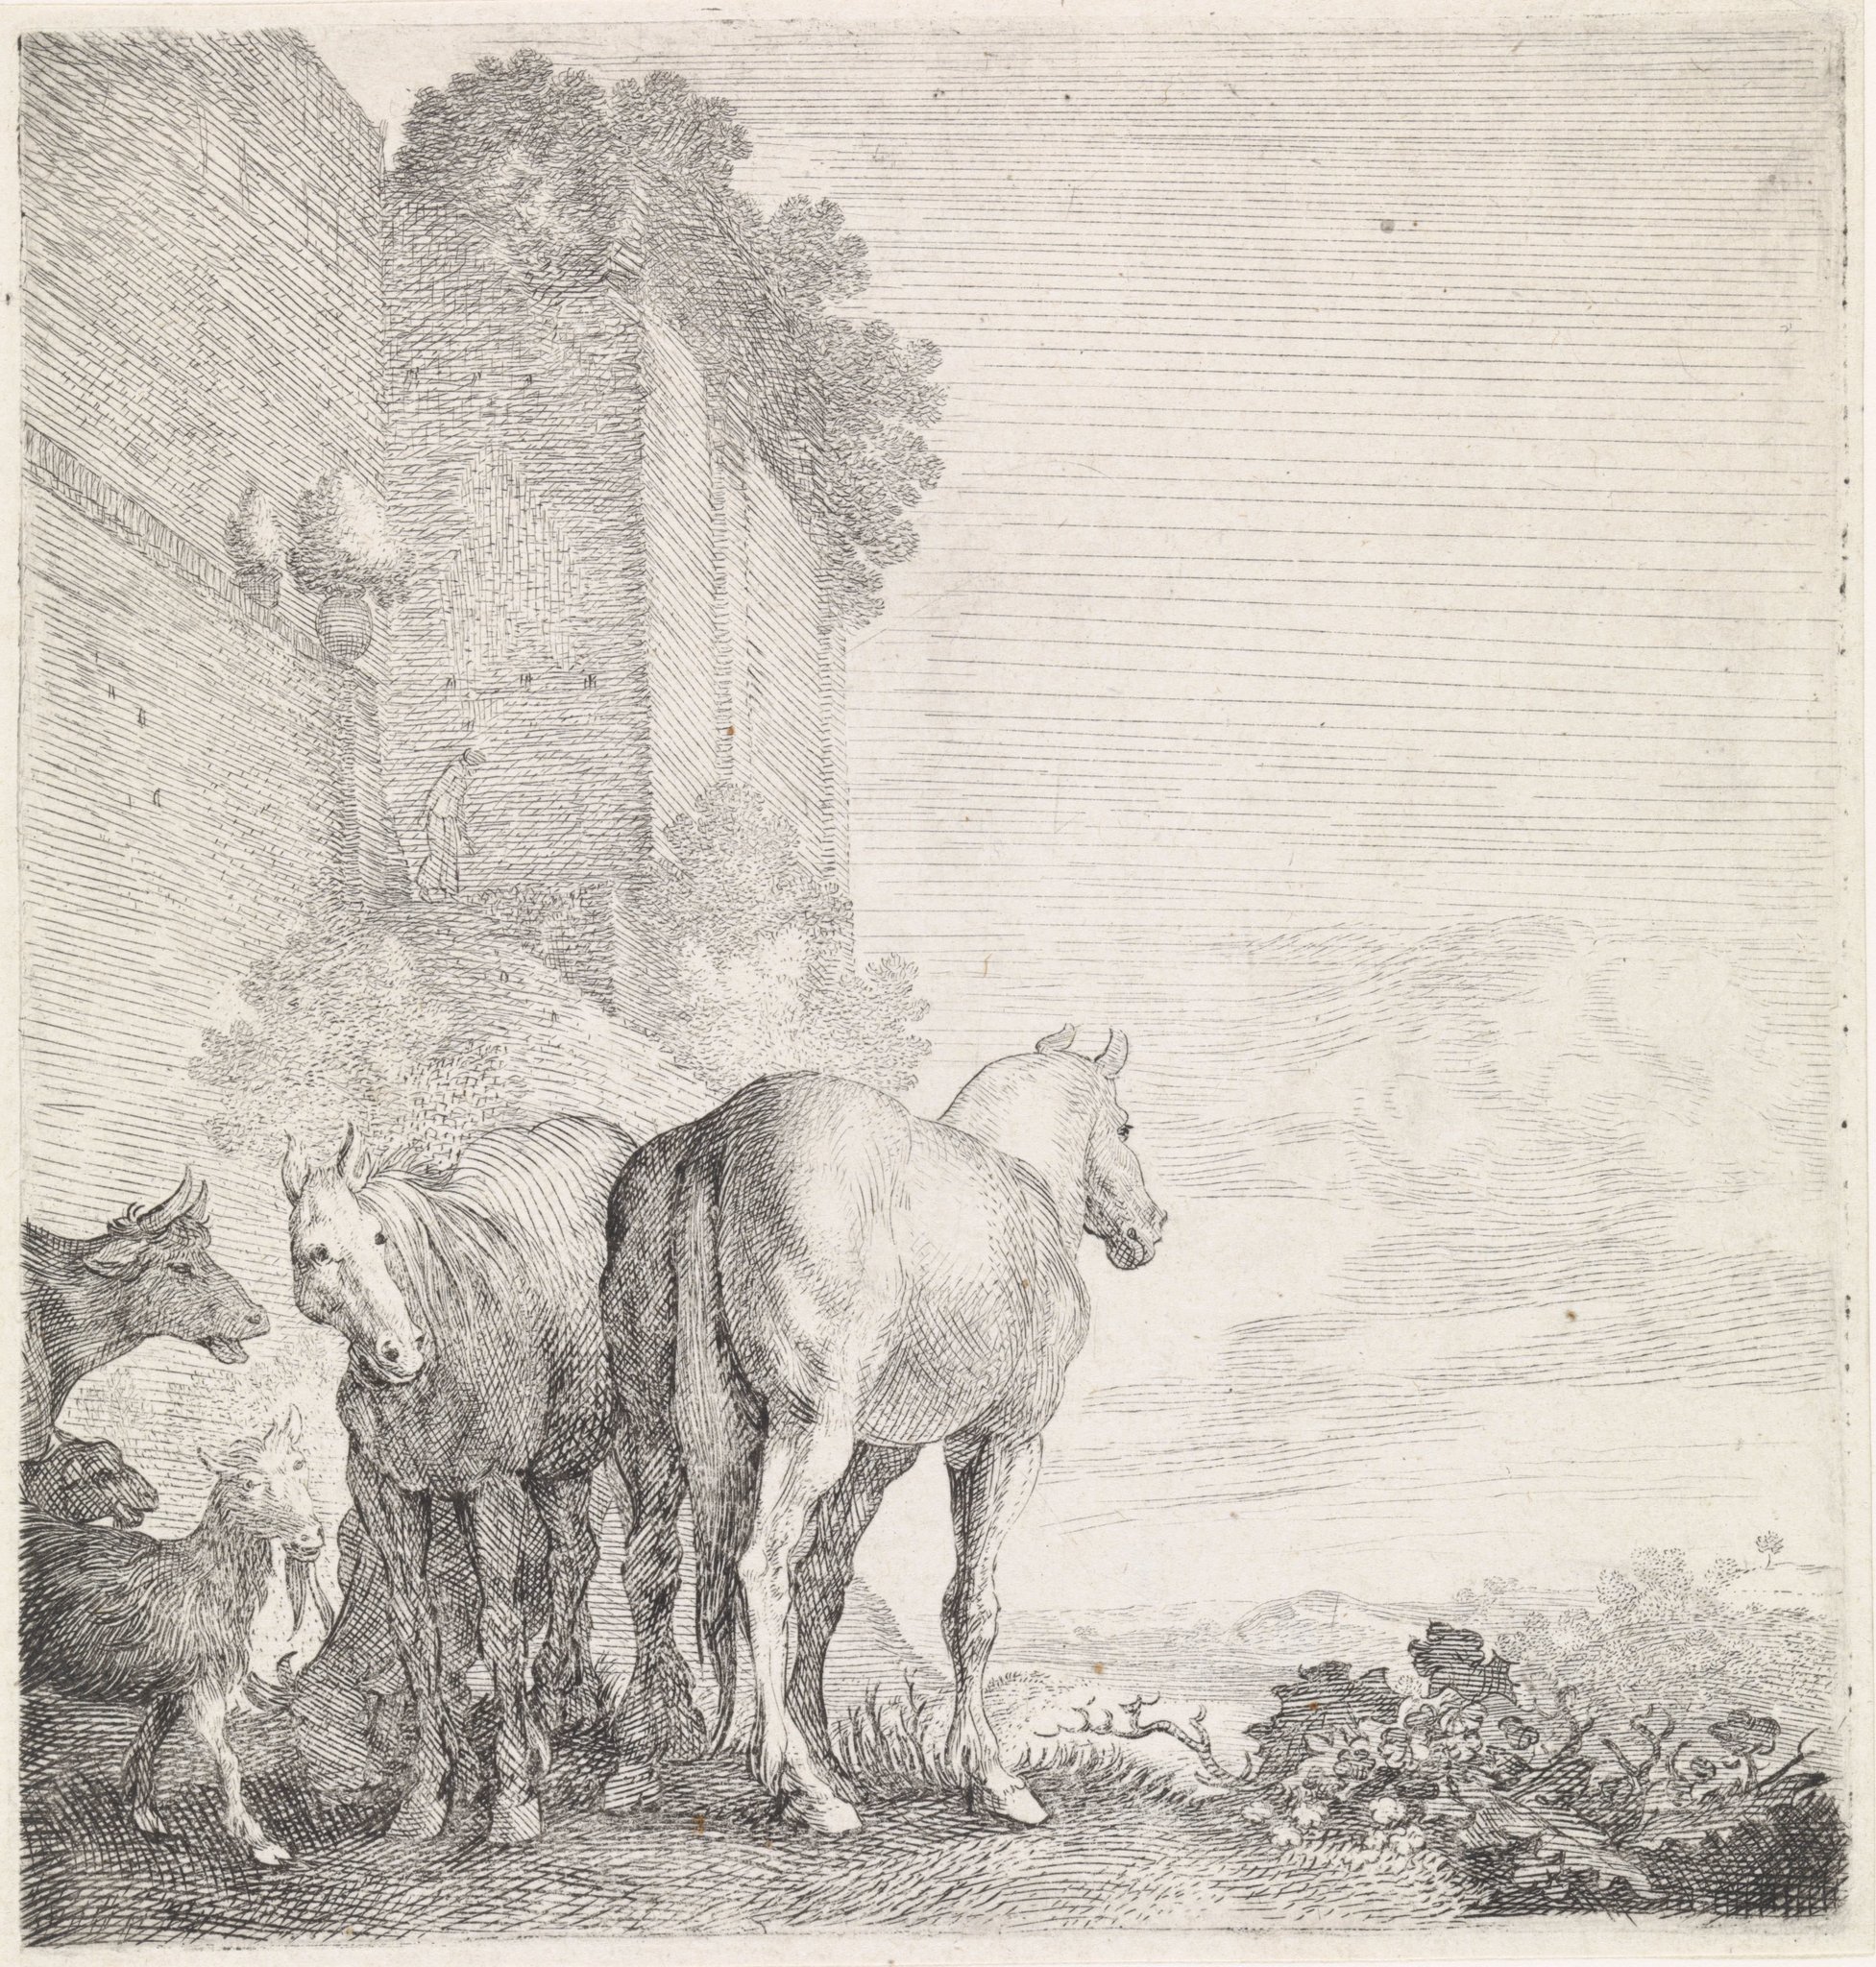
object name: print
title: Twee paarden met geiten en een koe bij een hoge (stads)muur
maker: moyses van wtenbrouck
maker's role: painter, print maker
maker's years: 1590-1647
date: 1600-1647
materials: paper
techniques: drypoint, engraving, etching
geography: the hague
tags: bovine cattle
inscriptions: collector's mark: Lugt 240